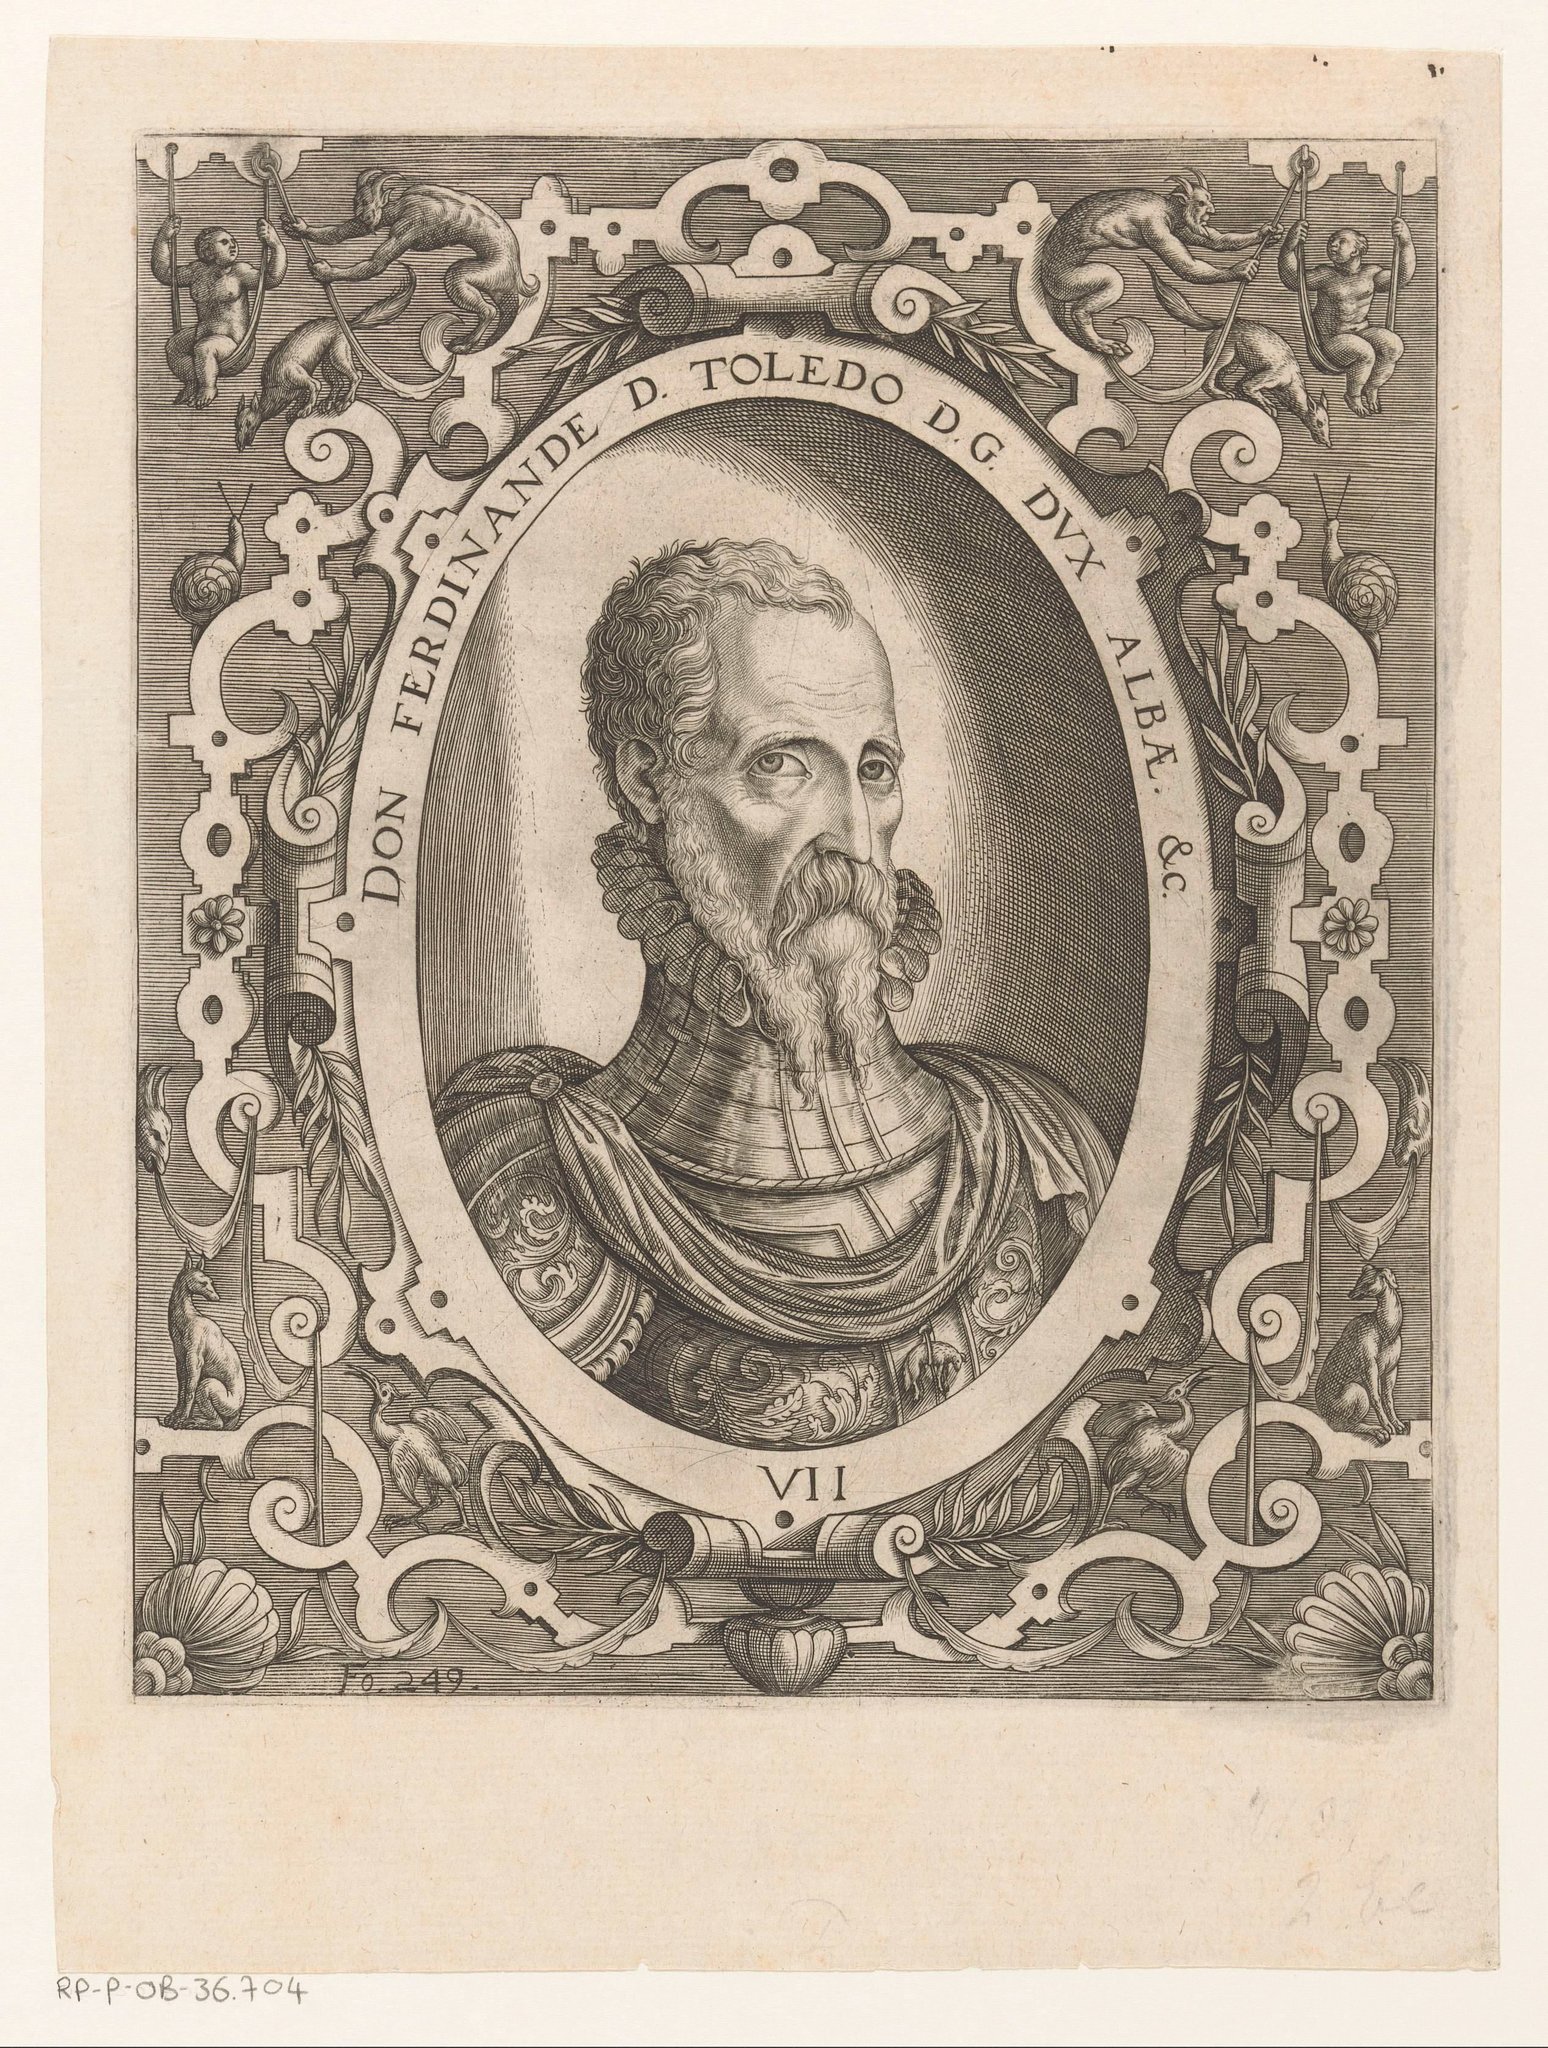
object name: print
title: Imagines Quorundam Principum et Illustrium Virorum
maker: niccolò nelli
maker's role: print maker, publisher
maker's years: 1535-1585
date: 1569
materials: paper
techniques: engraving, etching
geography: venice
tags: fernando álvarez de toledo (3rd duke of alba), ornament derived from animal forms, fruits and vegetables ~ ornament, historical persons, knighthood order of the golden fleece - insignia of a knighthood order, e.g.: badge, chain (with name of order)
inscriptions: collector's mark: Lugt 2228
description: Een portret van Fernando Álvarez de Toledo, in harnas met de ketting van de Orde van het Gulden Vlies, gevat in een ovaal omgeven door maniëristische siermotieven met dieren en saters. Genummerd linksonder: Fo. 249. Genummerd middenonder: VII.